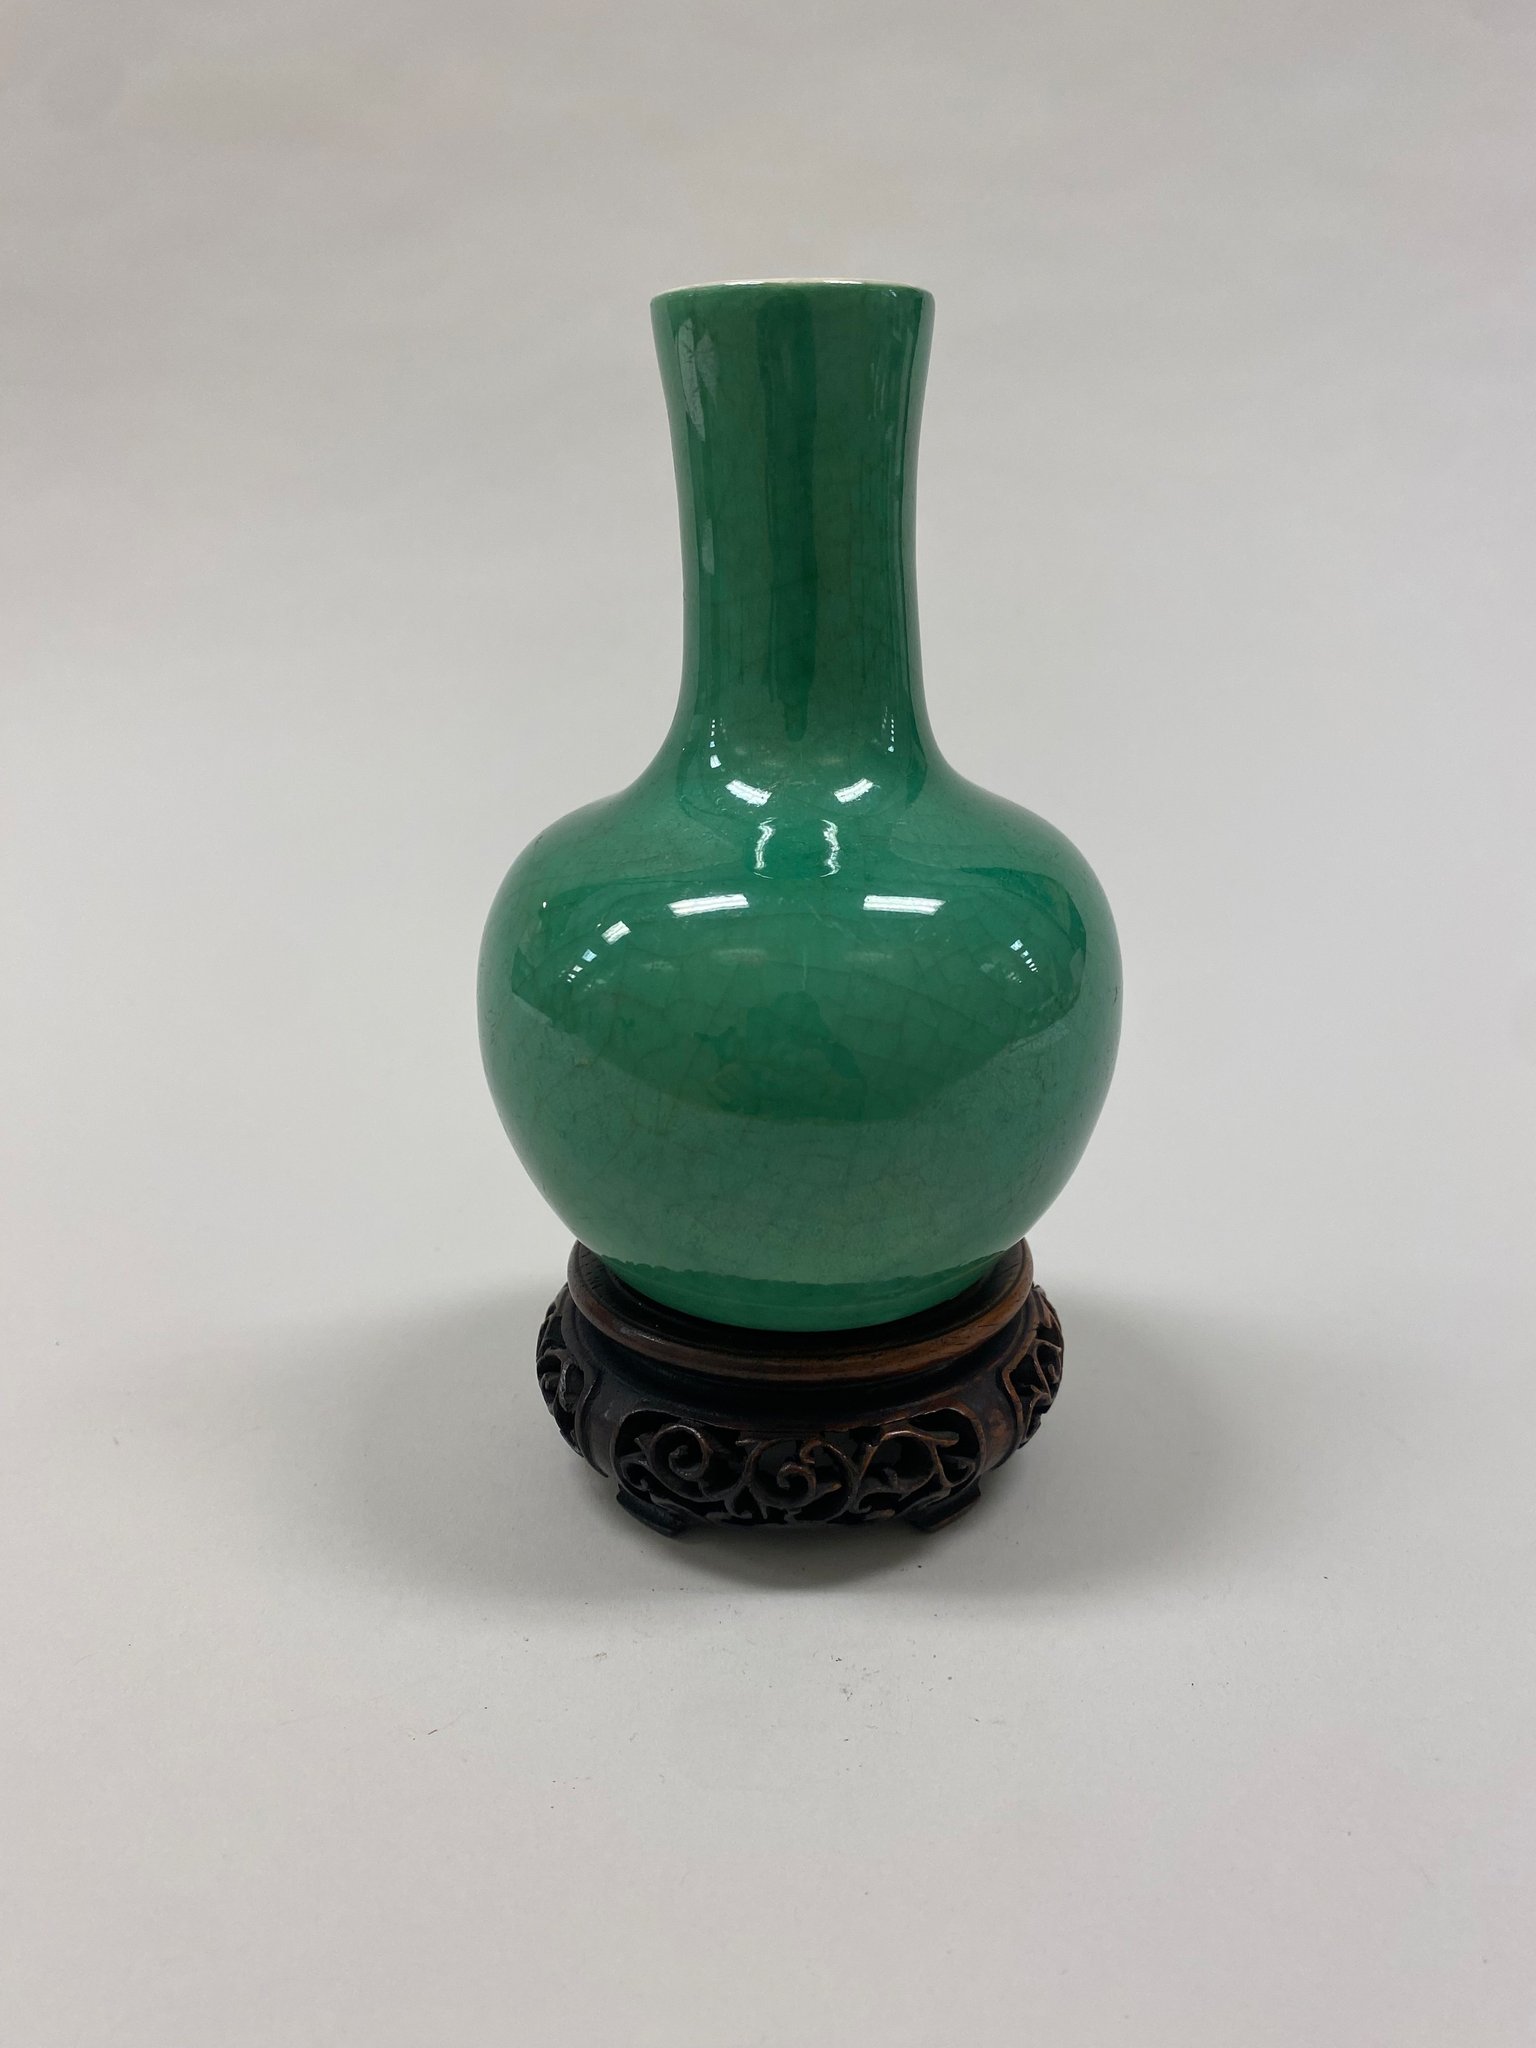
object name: bottle vase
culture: chinese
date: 1701-1800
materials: glaze, porcelain